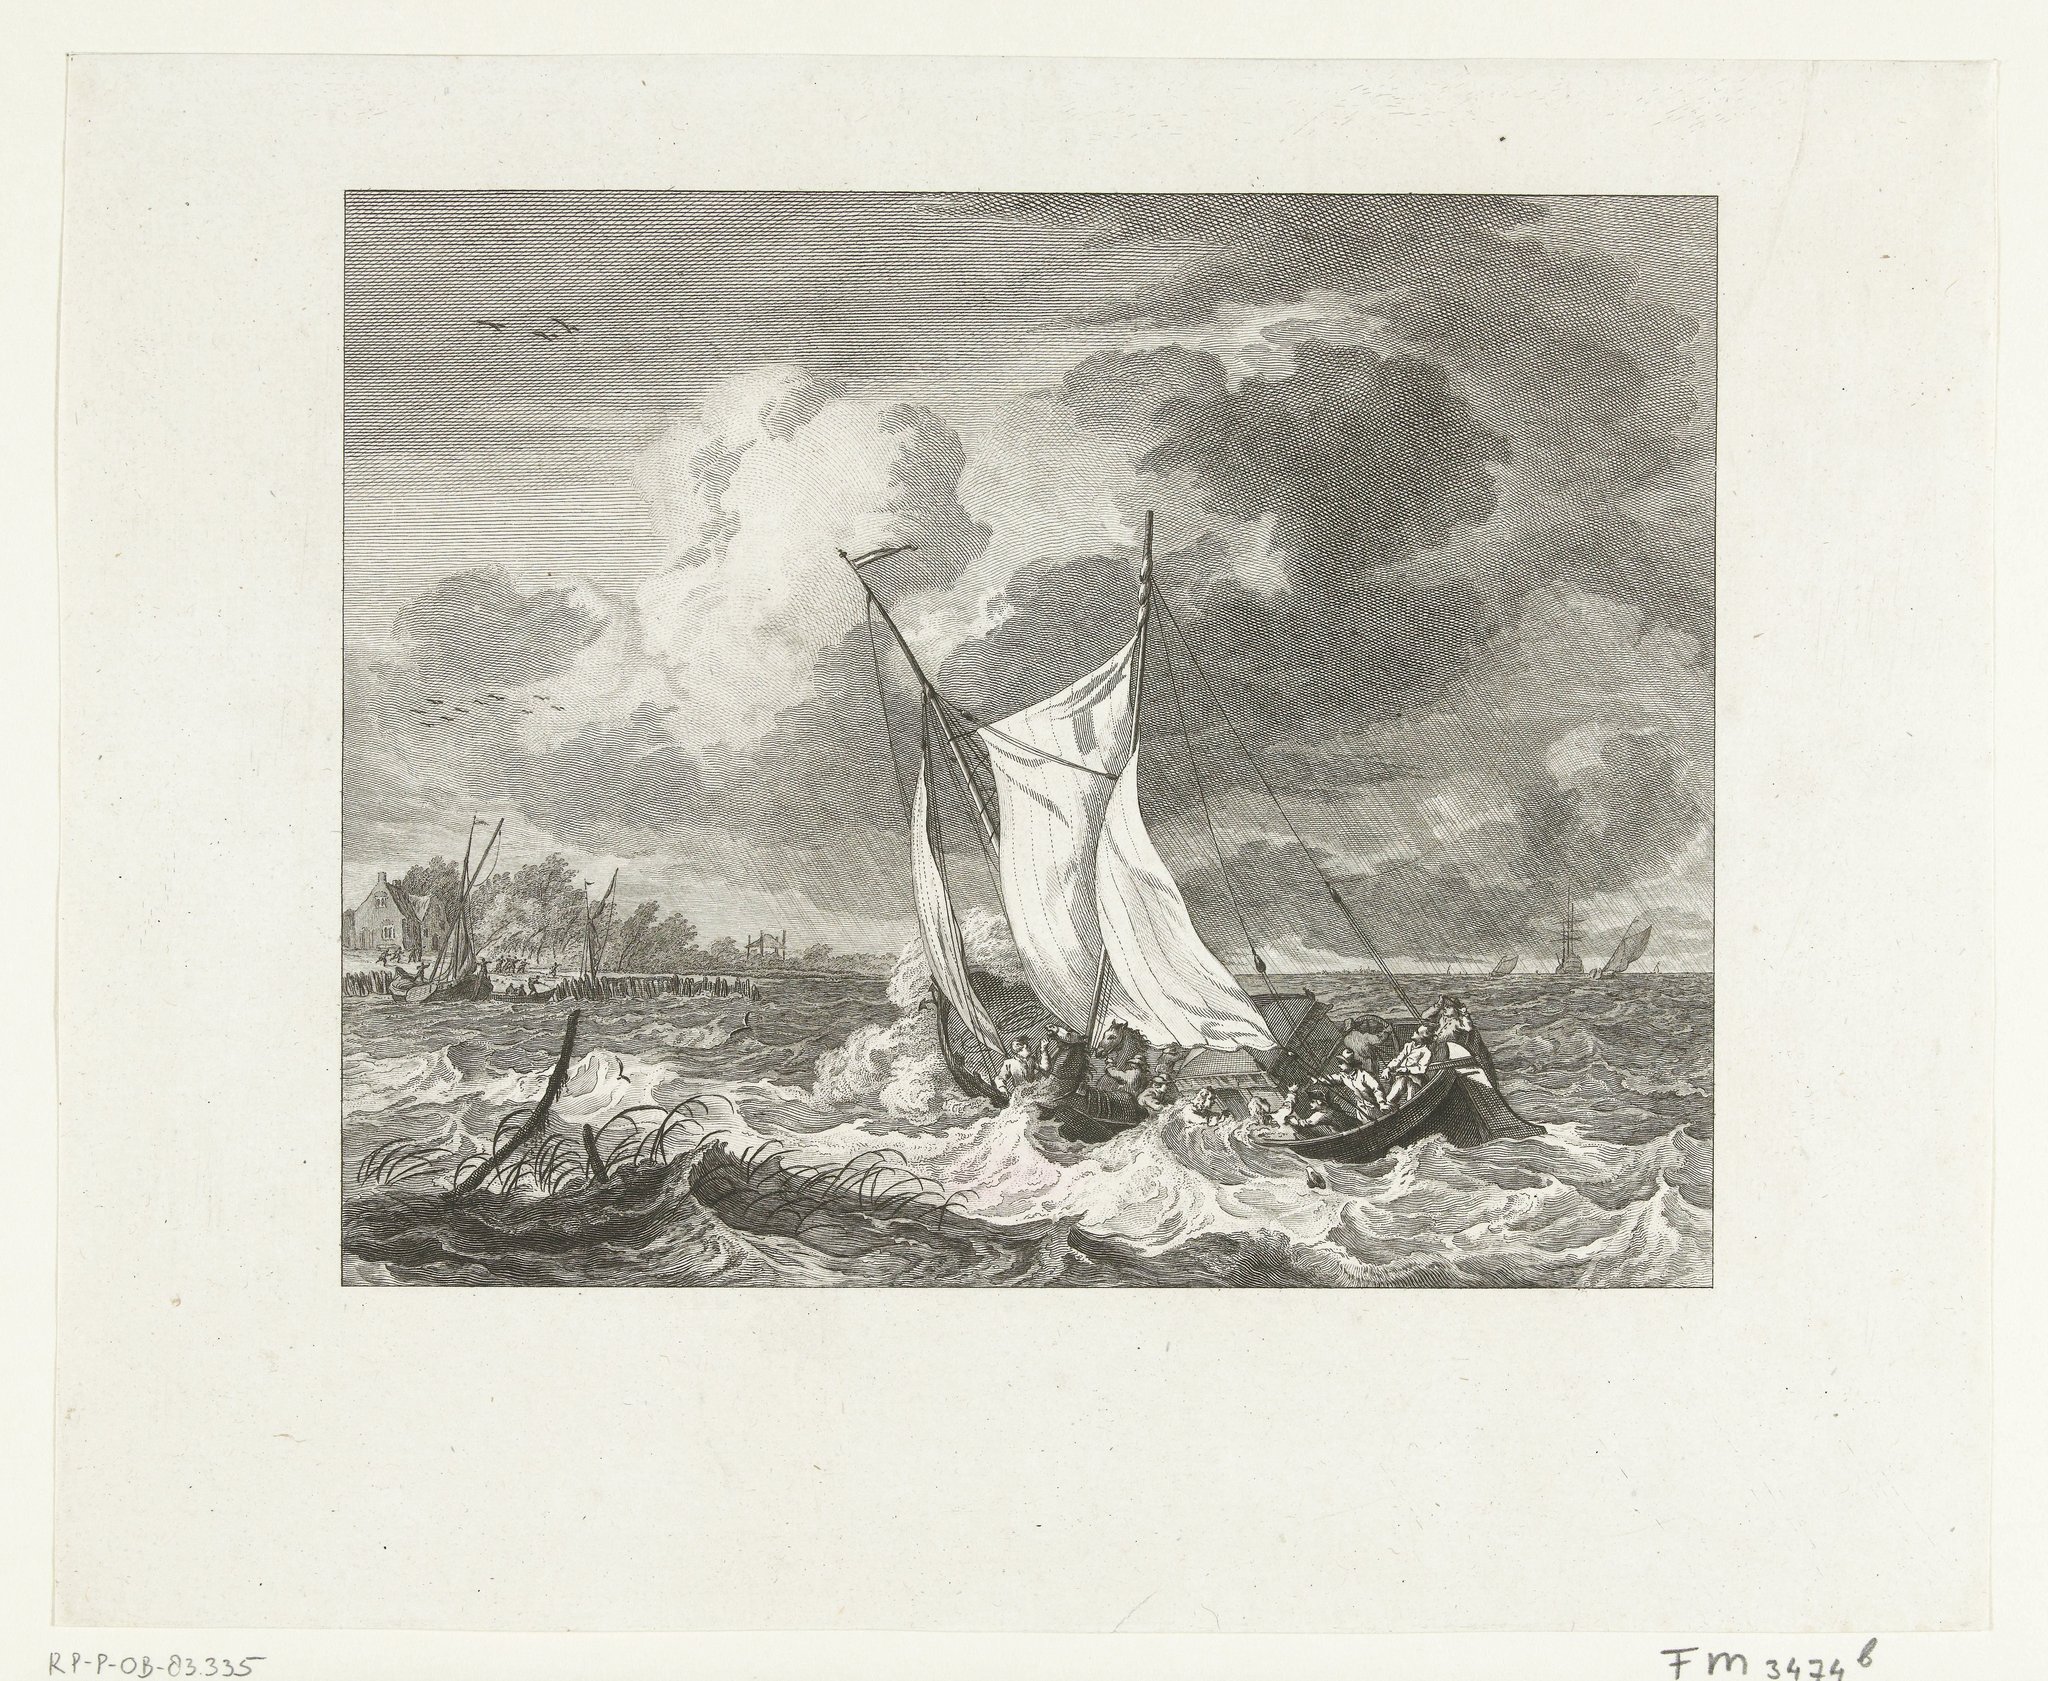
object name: print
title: Verdrinkingsdood van prins Johan Willem Friso, 1711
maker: reinier vinkeles (i)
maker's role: draughtsman, print maker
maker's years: 1741-1816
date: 1776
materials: paper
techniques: etching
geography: northern netherlands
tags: johan willem friso (prins van oranje-nassau), death by drowning (non-violent)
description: Johan Willem Friso, prins van Oranje-Nassau, verdrinkt tijdens het oversteken van de Moerdijk als de boot tijdens zwaar weer op 14 juli 1711 in problemen raakt.